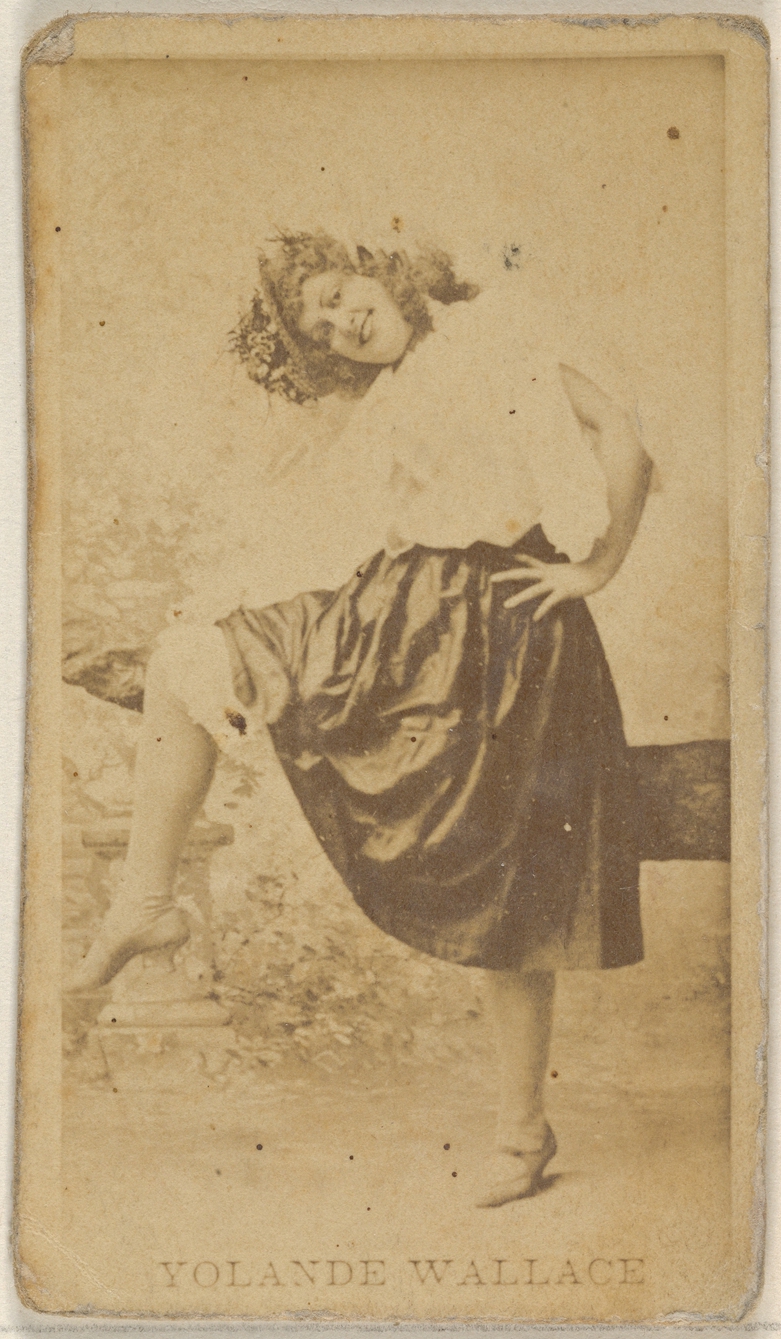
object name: photograph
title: Yolande Wallace, from the Actors and Actresses series (N45, Type 8) for Virginia Brights Cigarettes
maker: allen & ginter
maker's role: publisher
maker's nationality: american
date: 1888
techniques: albumen silver print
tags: portraits,women,actresses